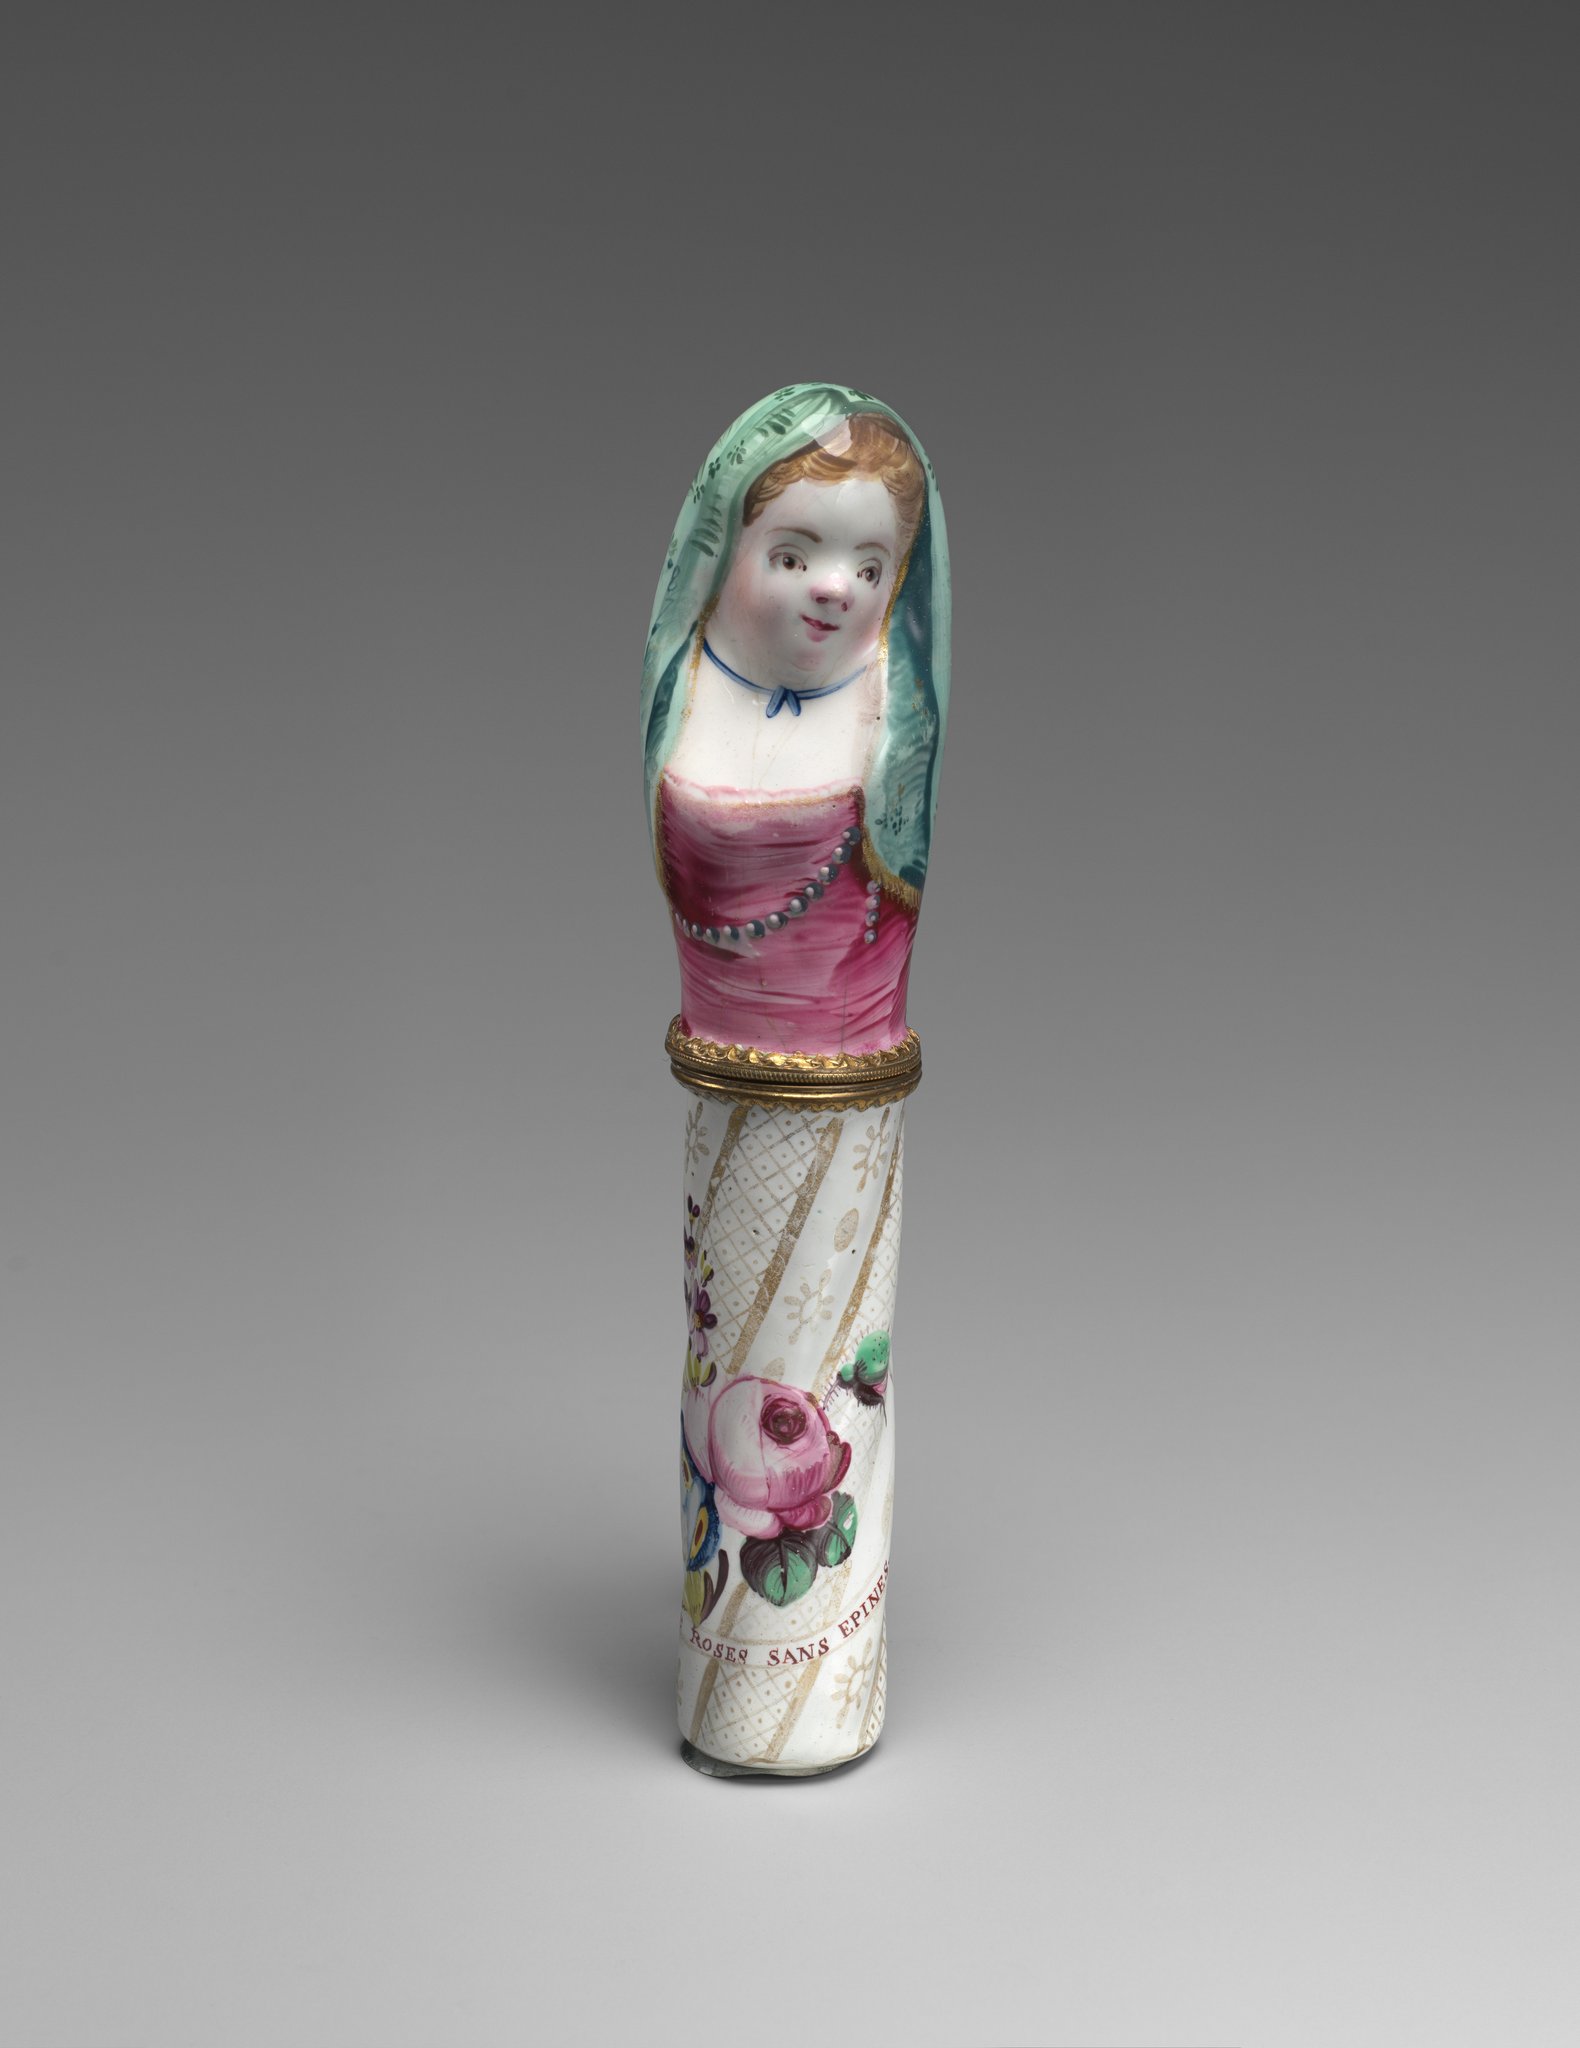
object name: bodkin case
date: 1770-1780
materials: copper, enamel